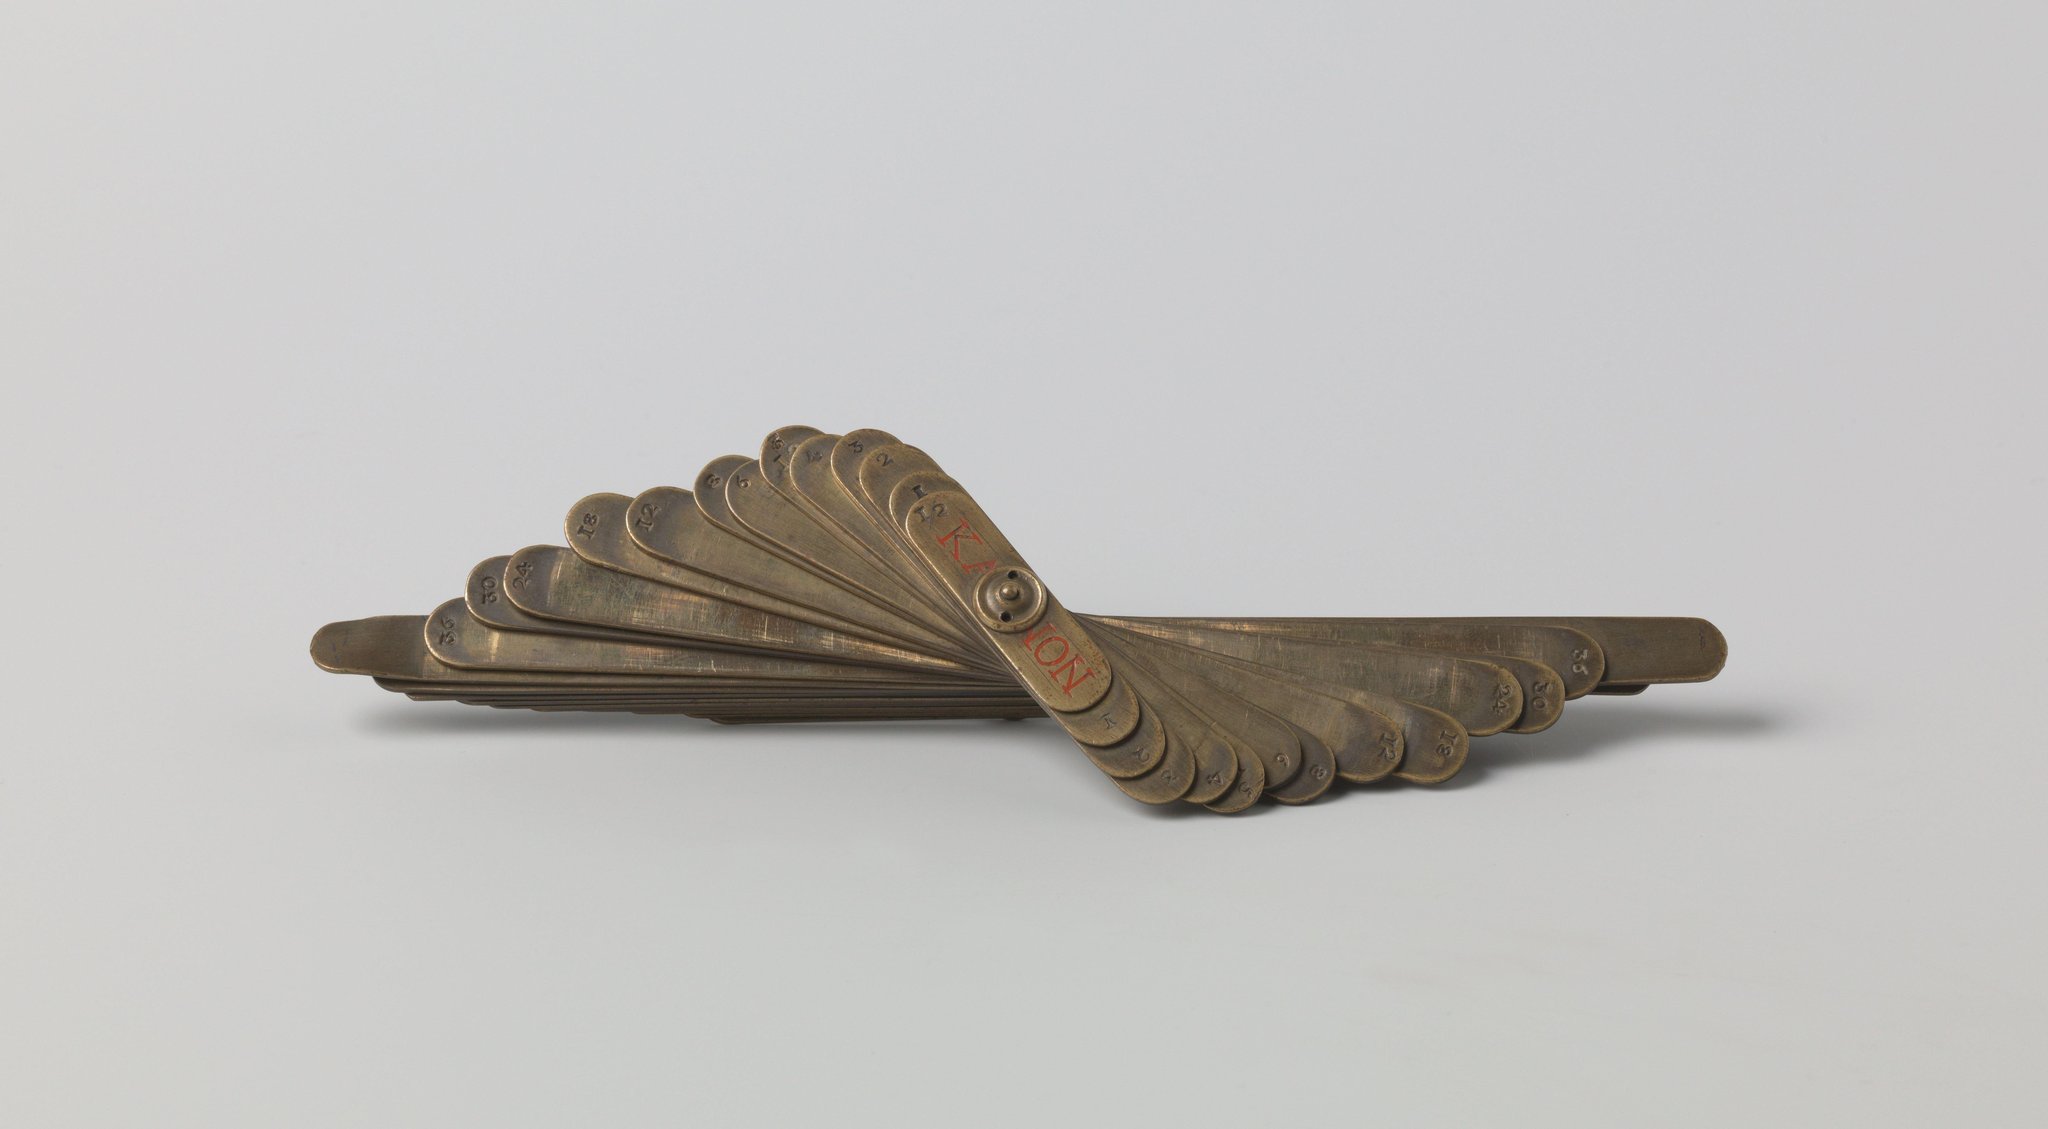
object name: kalibermaat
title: Kalibermaat voor vuurmonden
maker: Anonymous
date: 1700-1800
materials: brass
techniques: rolling, snipping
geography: netherlands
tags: netherlands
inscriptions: number: ‘KARONADES / 6, 8, 12, 18, 24, 30, 36, 42, 48, 64. KANON / ½, 1, 2, 3, 4, 5, 6, 8, 12, 18, 24, 30, 36’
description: Zogenaamde 'voelmaat', waarmee je opgetreden speling kunt opmeten bestaande uit 23 in grootte variërende platte staafjes. De staven liggen op elkaar en zijn afzonderlijk van elkaar draaibaar om een as. De staven hebben aan boven en onderzijde het opschrift: KARONADES / 6, 8, 12, 18, 24, 30, 36, 42, 48, 64. KANON / ½, 1, 2, 3, 4, 5, 6, 8, 12, 18, 24, 30, 36.